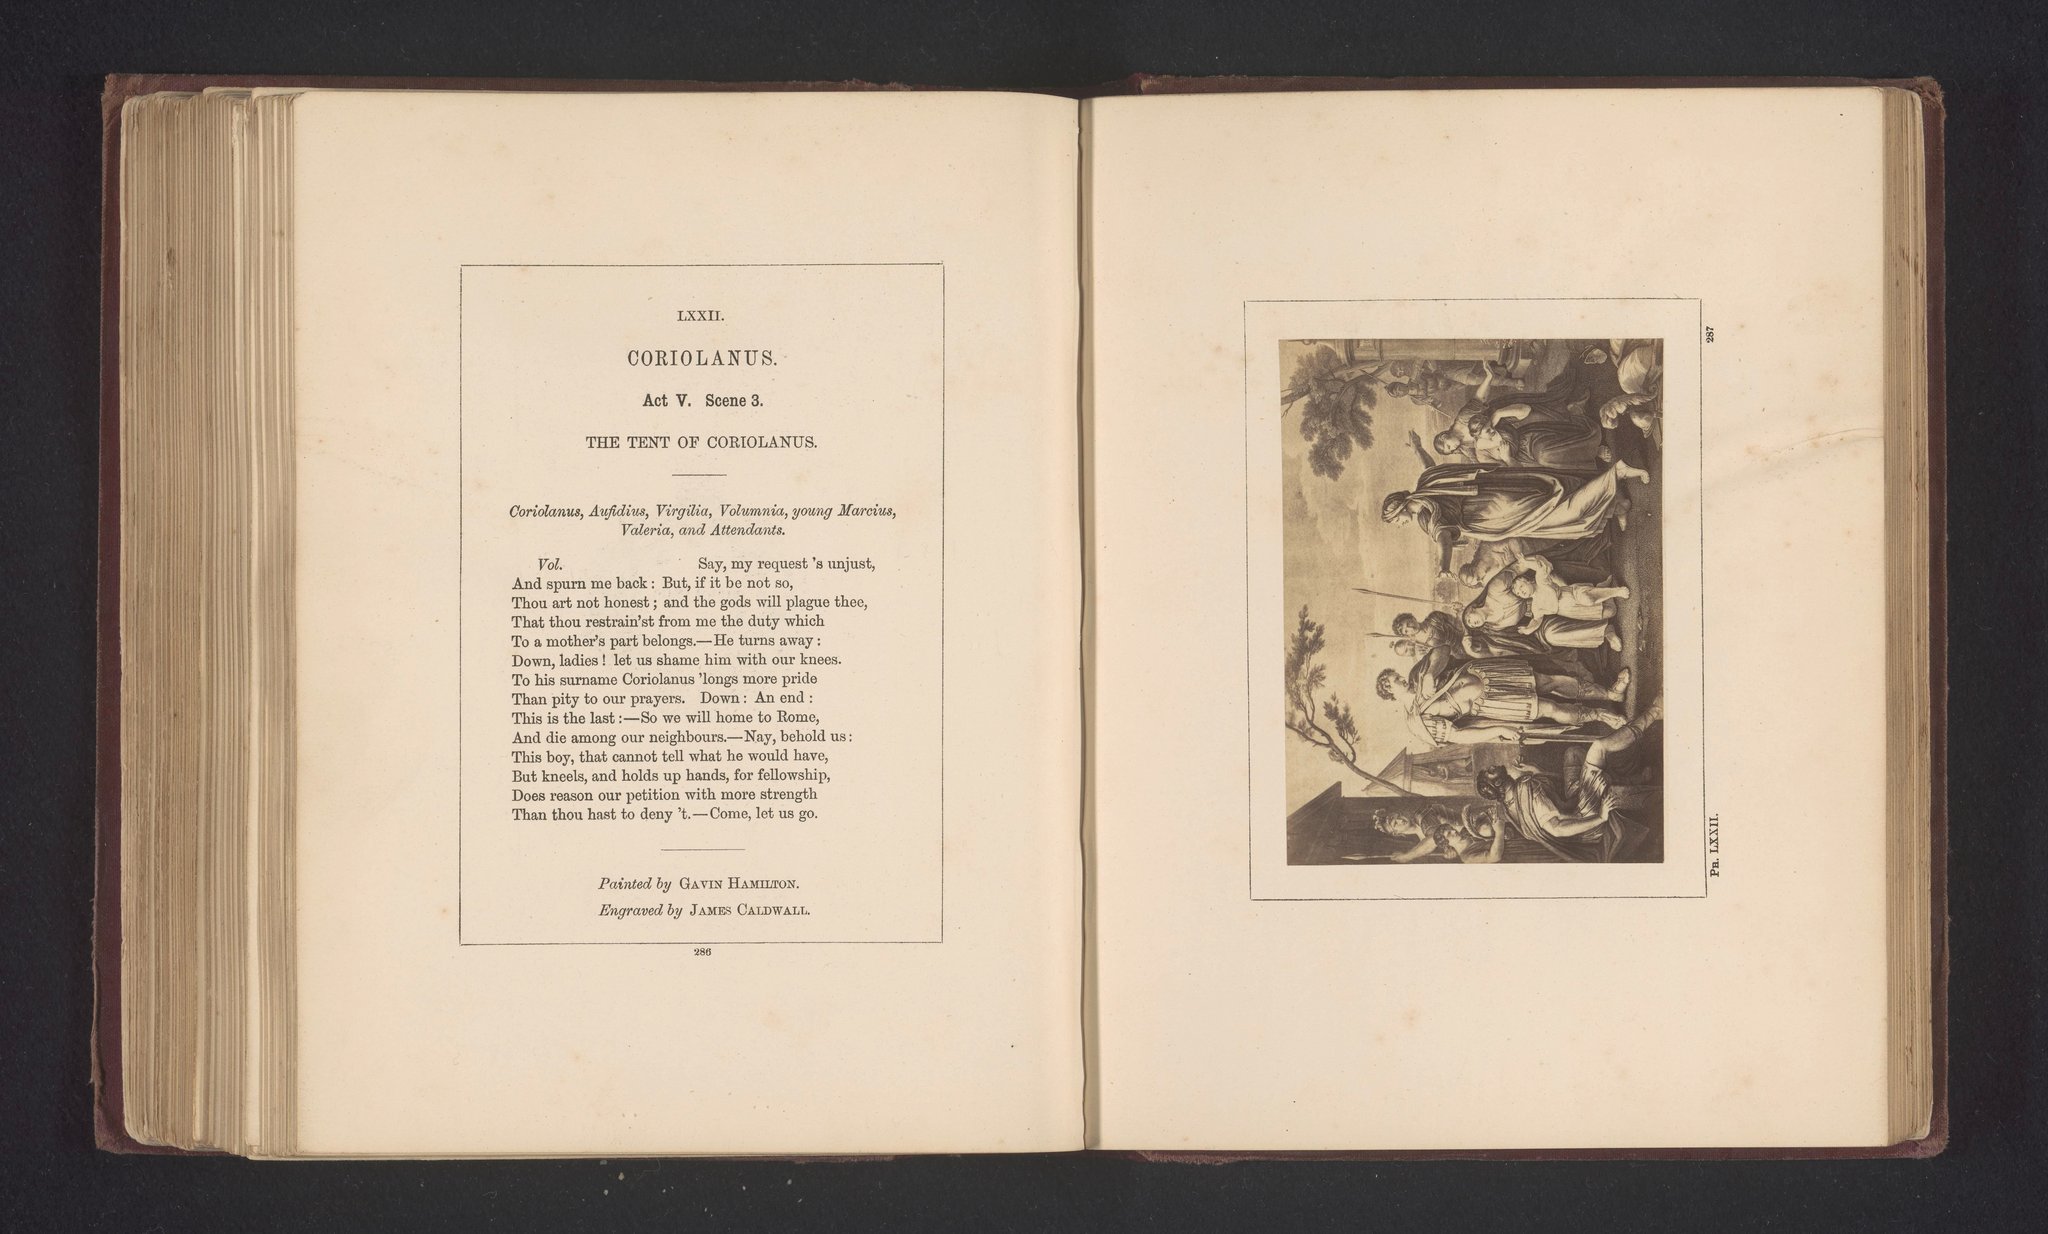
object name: photograph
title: Fotoreproductie van een prent naar een schilderij door Gavin Hamilton, voorstellend een scene uit Coriolanus door William Shakespeare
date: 1854-1867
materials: photographic support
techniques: albumen print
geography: london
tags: specific works of literature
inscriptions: number: ‘Ph. LXXII. 287’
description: Te zien is akte V, scene 3 met een gezelschap voor de tent van Gaius Marcius Coriolanus.